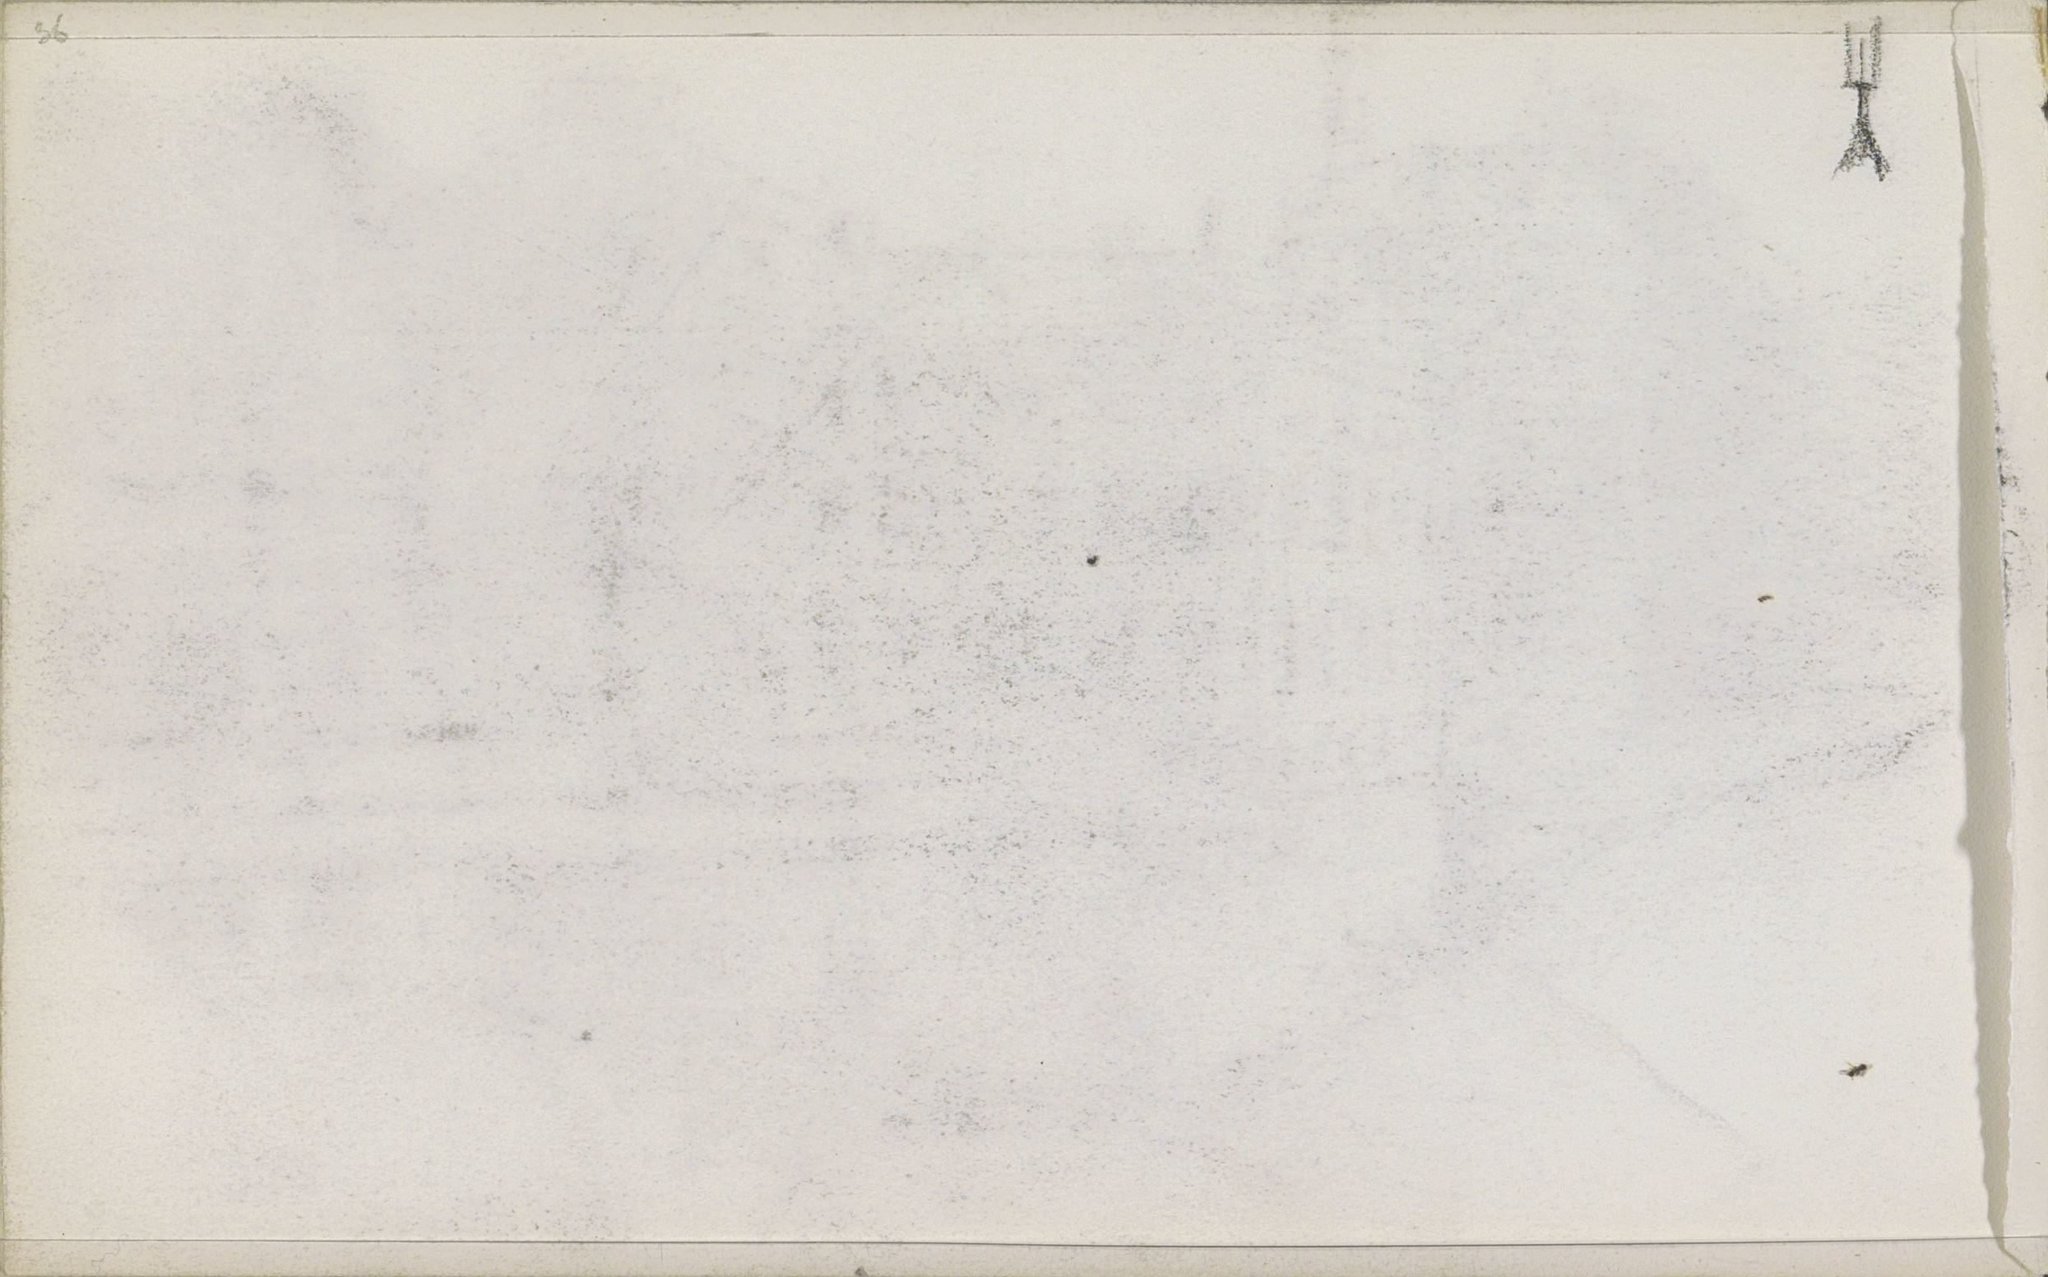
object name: sketchbook leaf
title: Studie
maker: willem witsen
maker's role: draughtsman, painter, print maker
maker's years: 1860-1923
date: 1806-1878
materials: chalk, paper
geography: gelderland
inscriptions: date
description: Pagina 36 uit een schetsboek met 23 bladen.